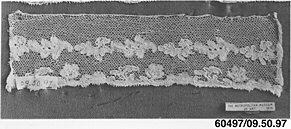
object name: strip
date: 1701-1800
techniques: lace